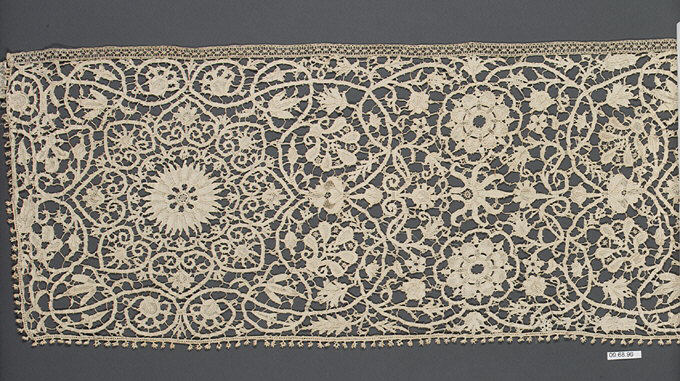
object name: border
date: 1600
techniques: lace